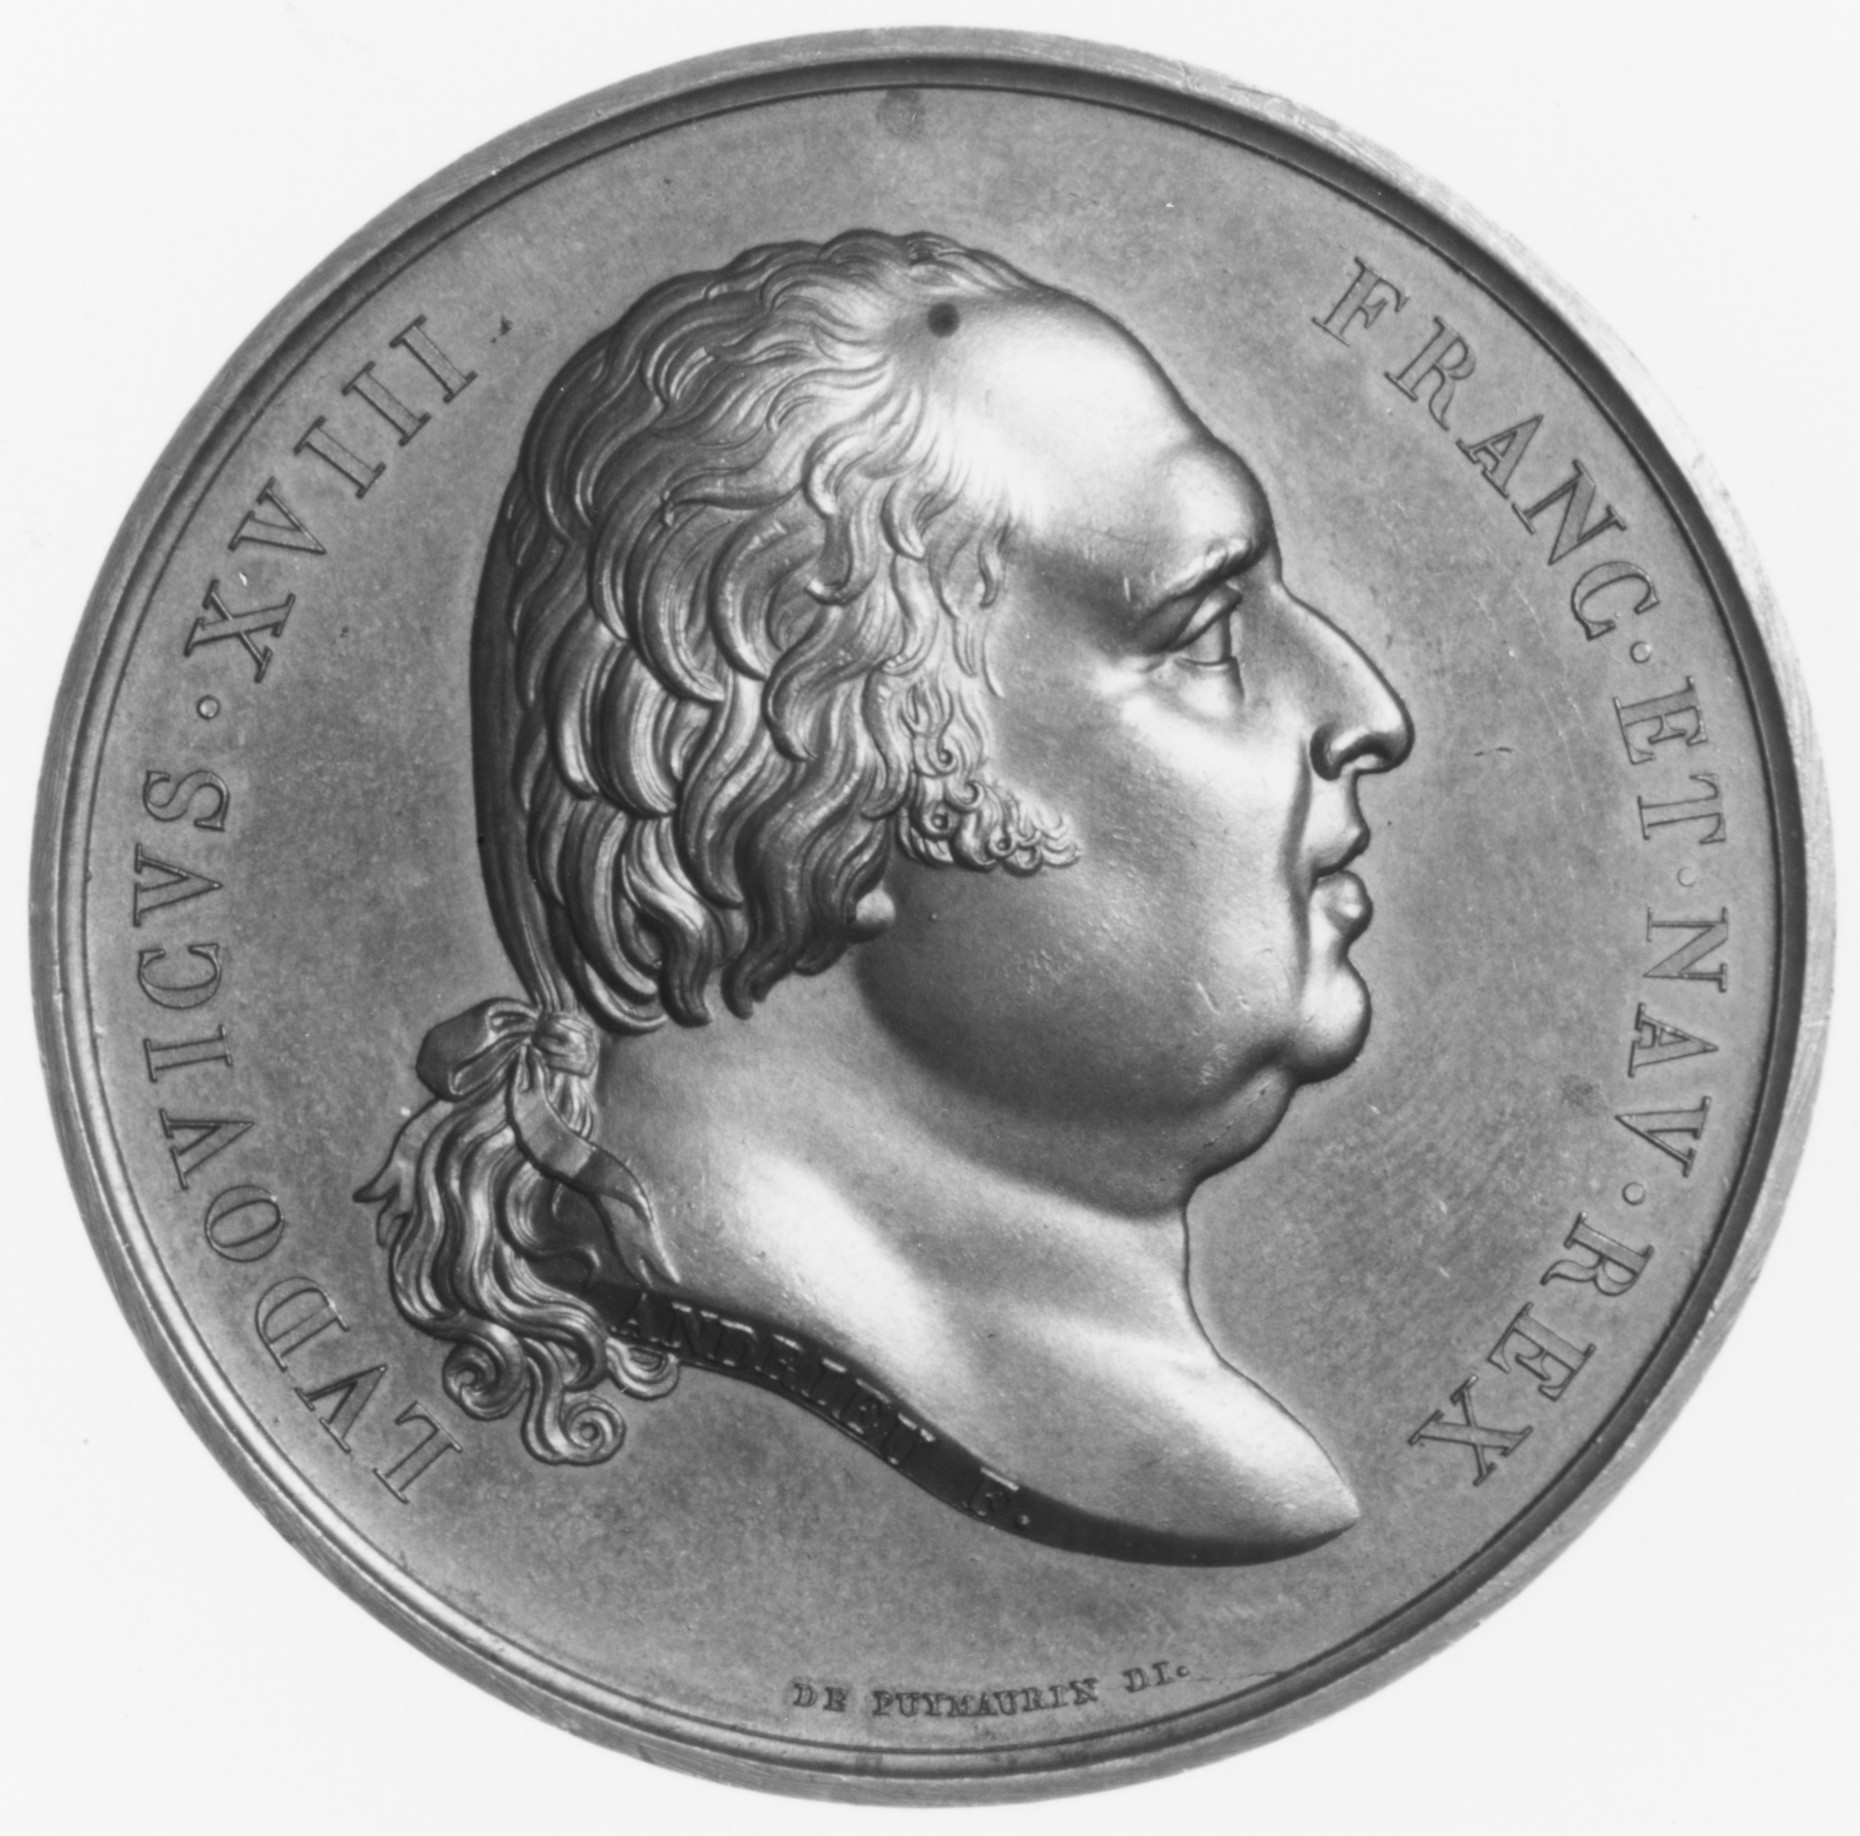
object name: medal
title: Louis XVIII, King of France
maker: bertrand andrieu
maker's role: artist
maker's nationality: french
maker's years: 1761-1822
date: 1814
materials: bronze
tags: kings,profiles